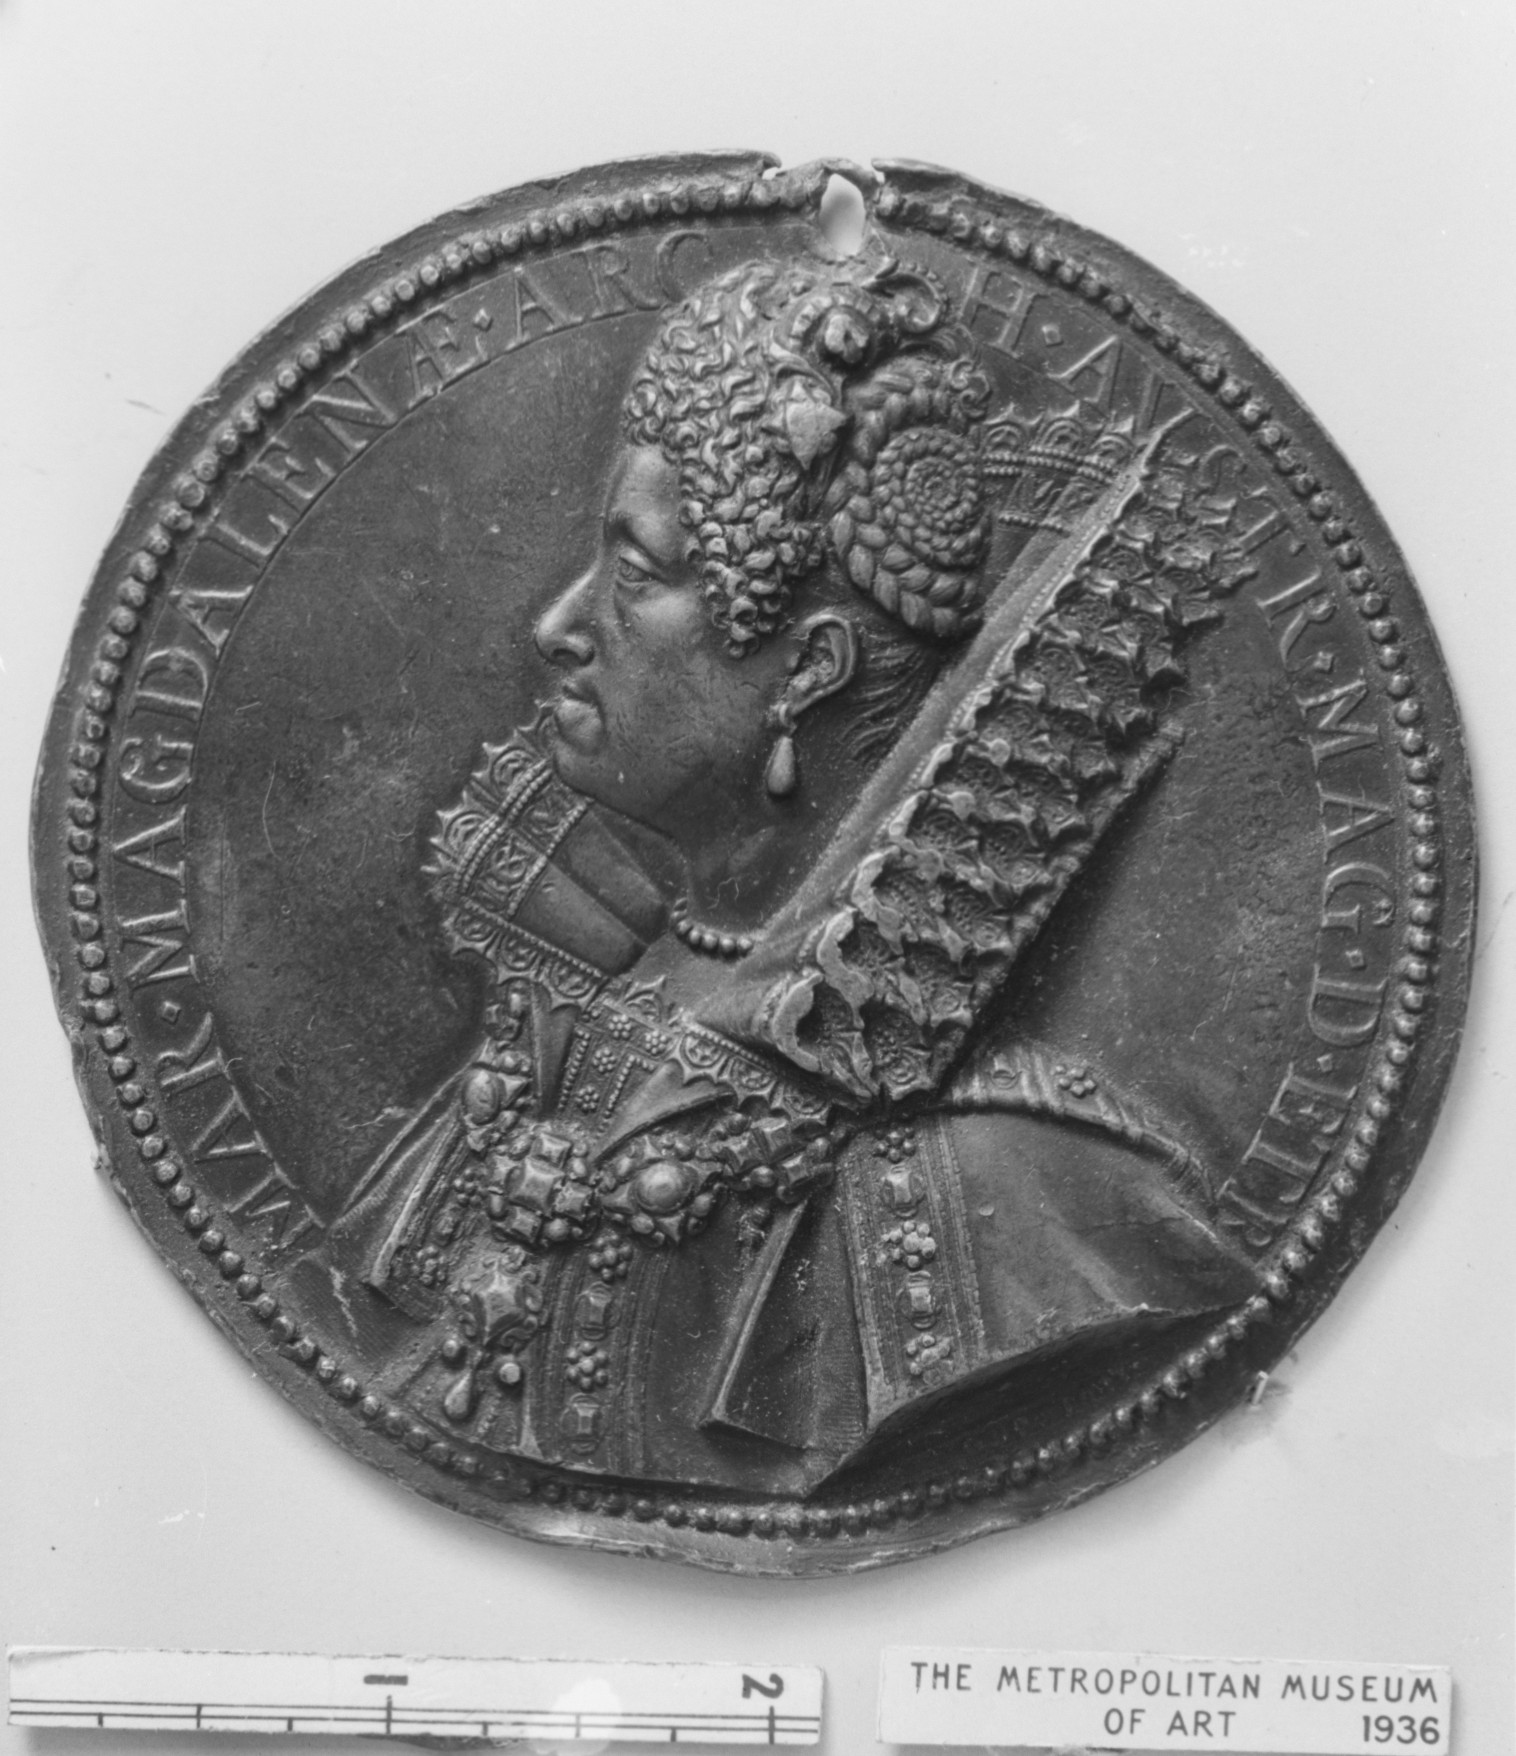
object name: medal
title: Maria Magdalena, Archduchess of Austria, Grand Duchess of Tuscany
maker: guillaume dupré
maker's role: artist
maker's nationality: french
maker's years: 1579-1640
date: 1613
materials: lead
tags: profiles,women